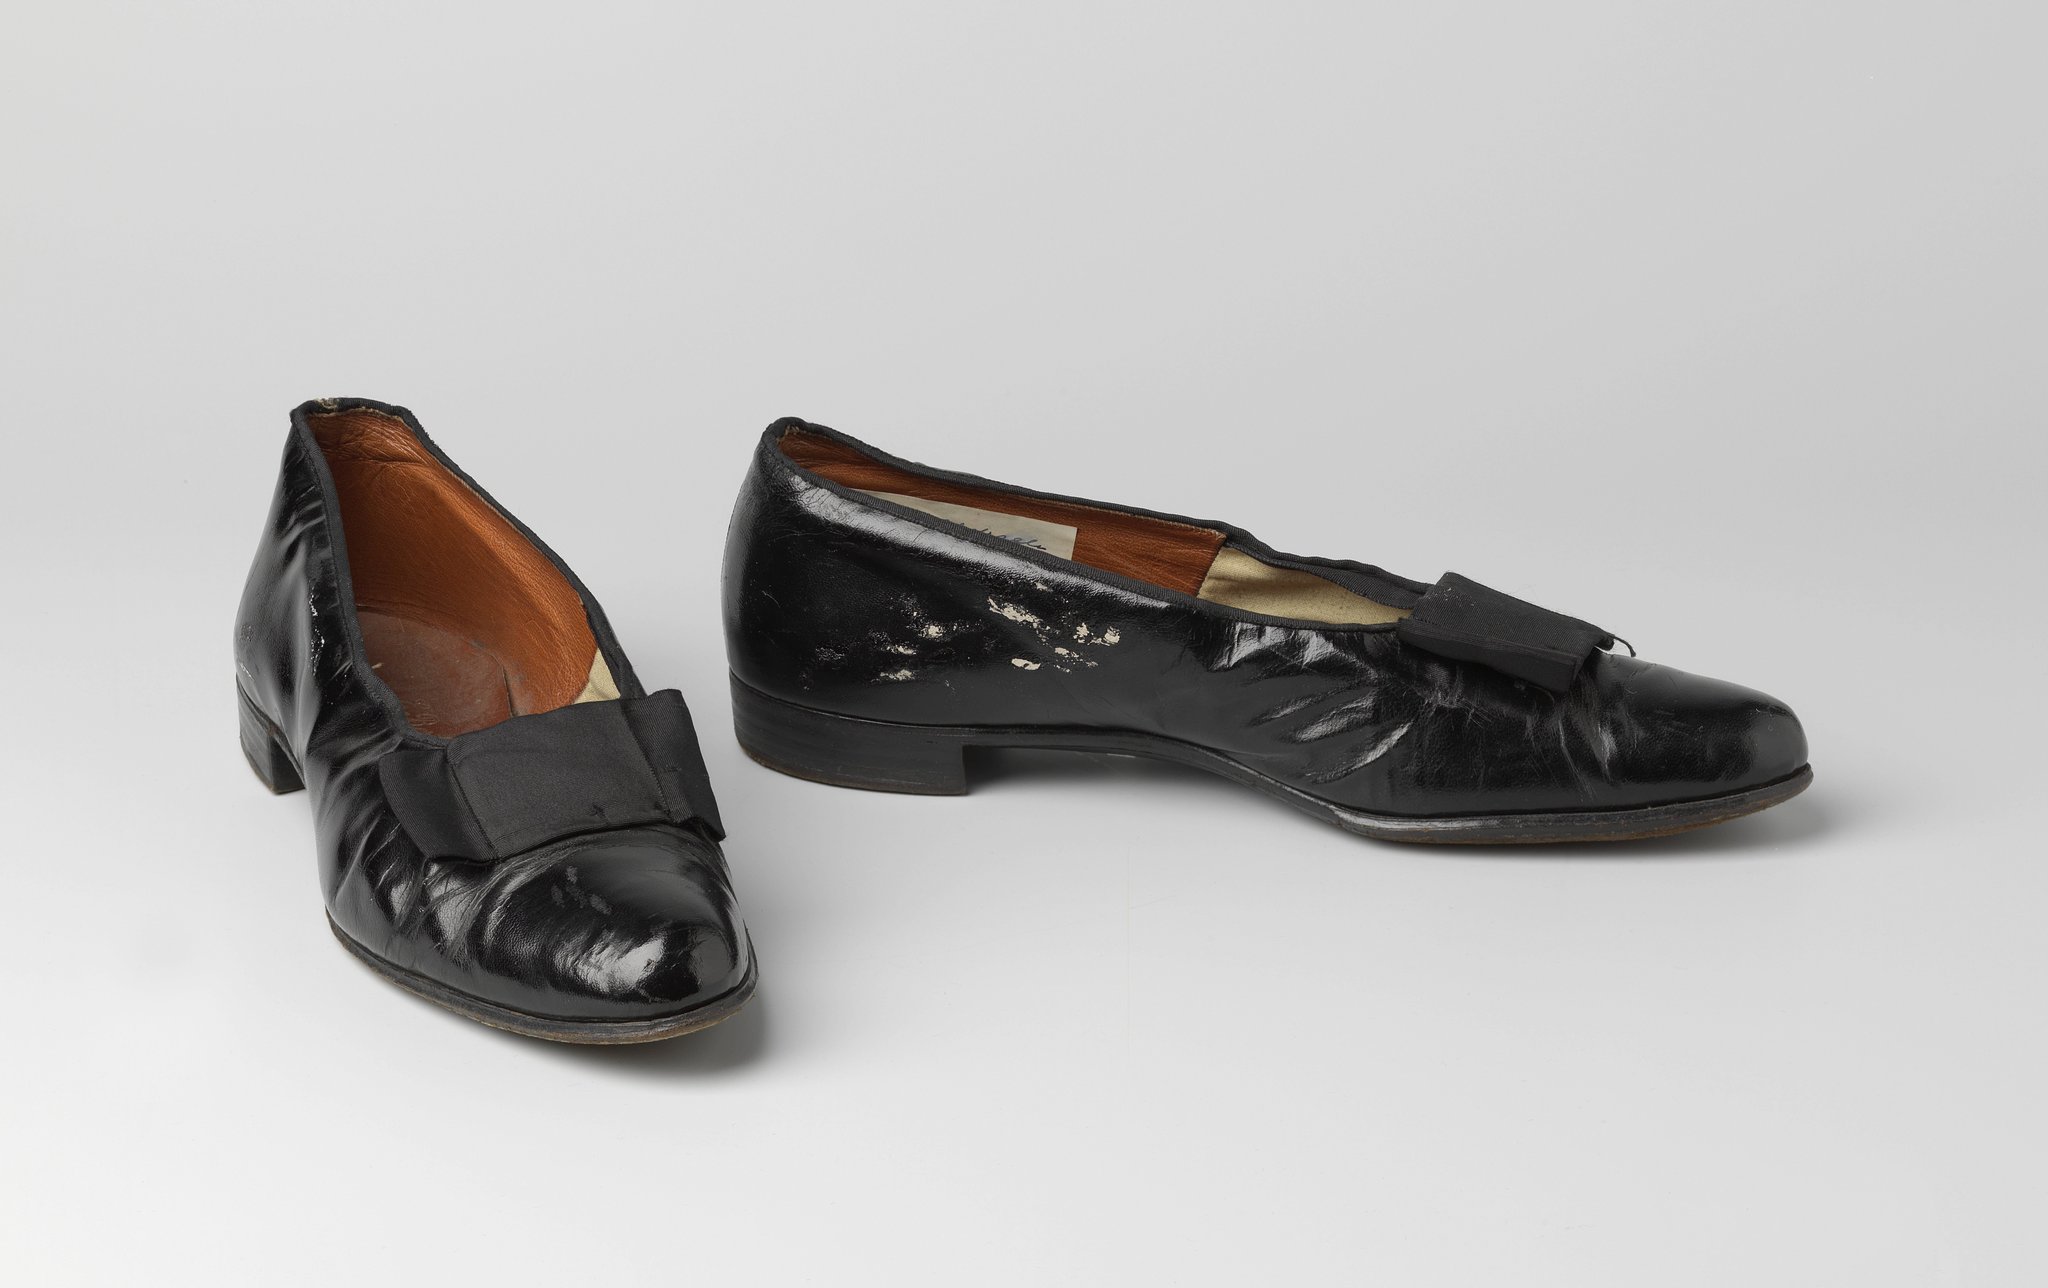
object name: herenpump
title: Herenbalschoen van zwart lakleer met strik van zwart ripslint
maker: e. bertrand (of f.)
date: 1930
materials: cotton, leather, silk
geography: brussels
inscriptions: name: ‘E. (of F.) Bertrand / 45 Ch.ée de Wavre / BRUXELLES.’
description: Rechterherenbalschoen van zwart lakleer. Model: puntneus, zeer platte hak. Het bovenblad uit één stuk gesneden. Versierd met breed strikje van zwart ripslint. Gevoerd met bruin leer en katoen.